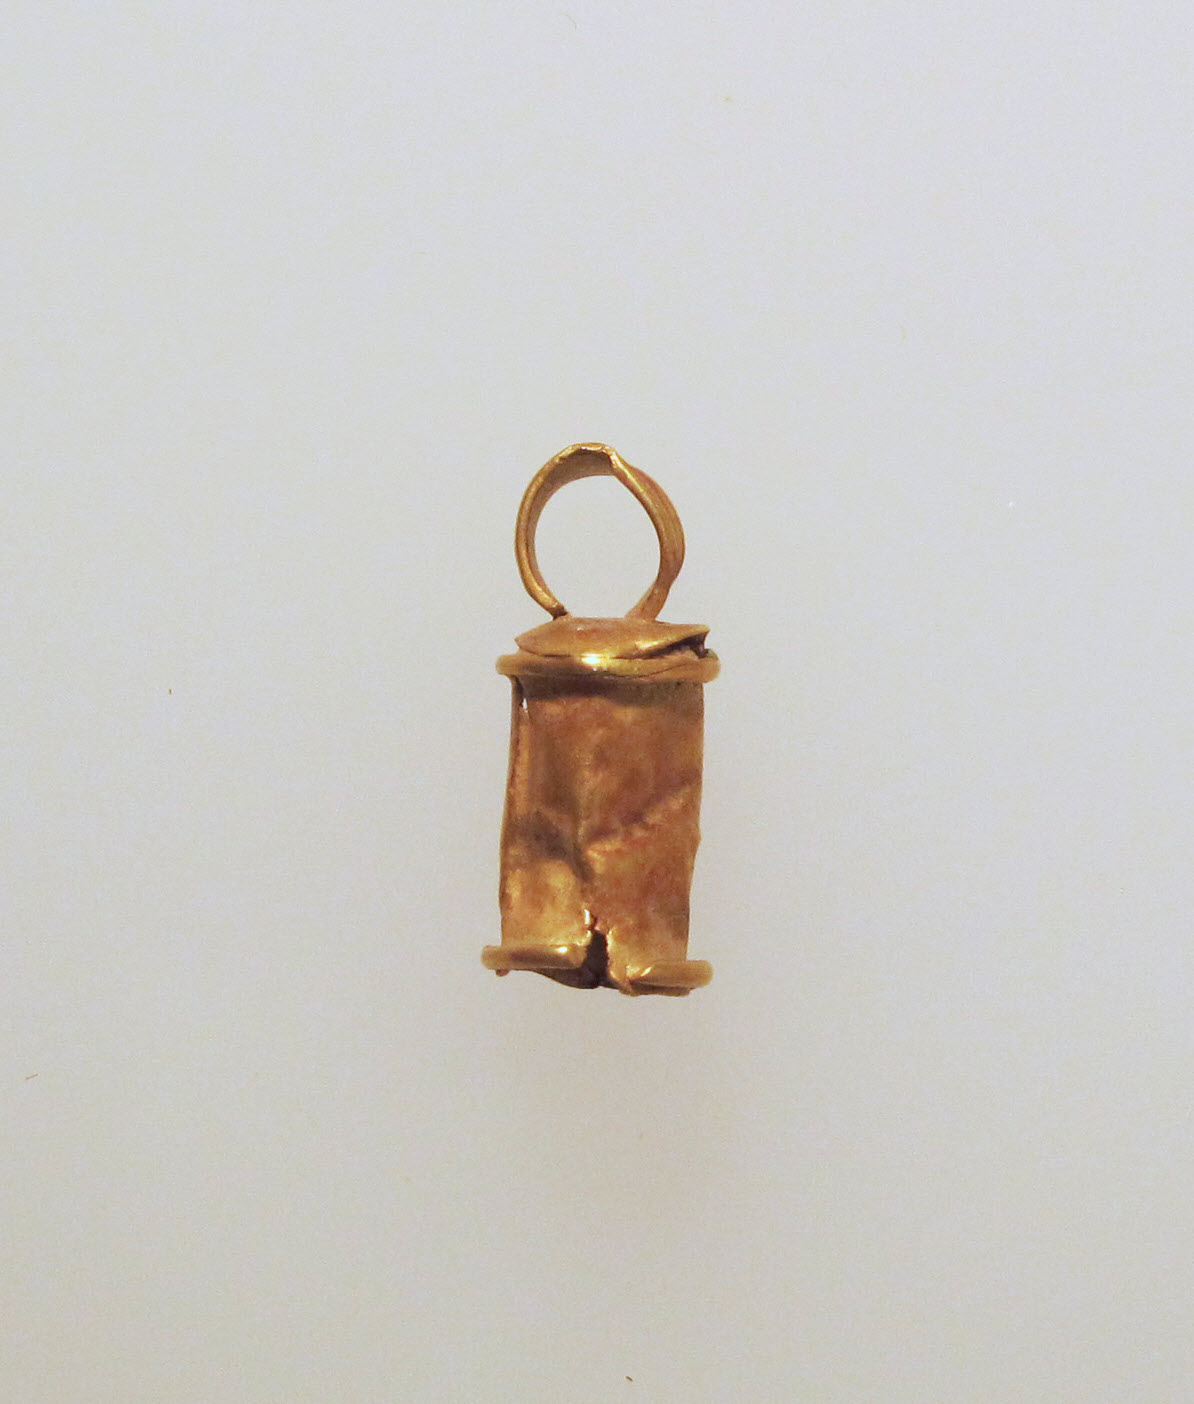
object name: bead pendant, tubular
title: Bead pendants, tubular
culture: cypriot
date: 3900 BCE-100 CE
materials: gold